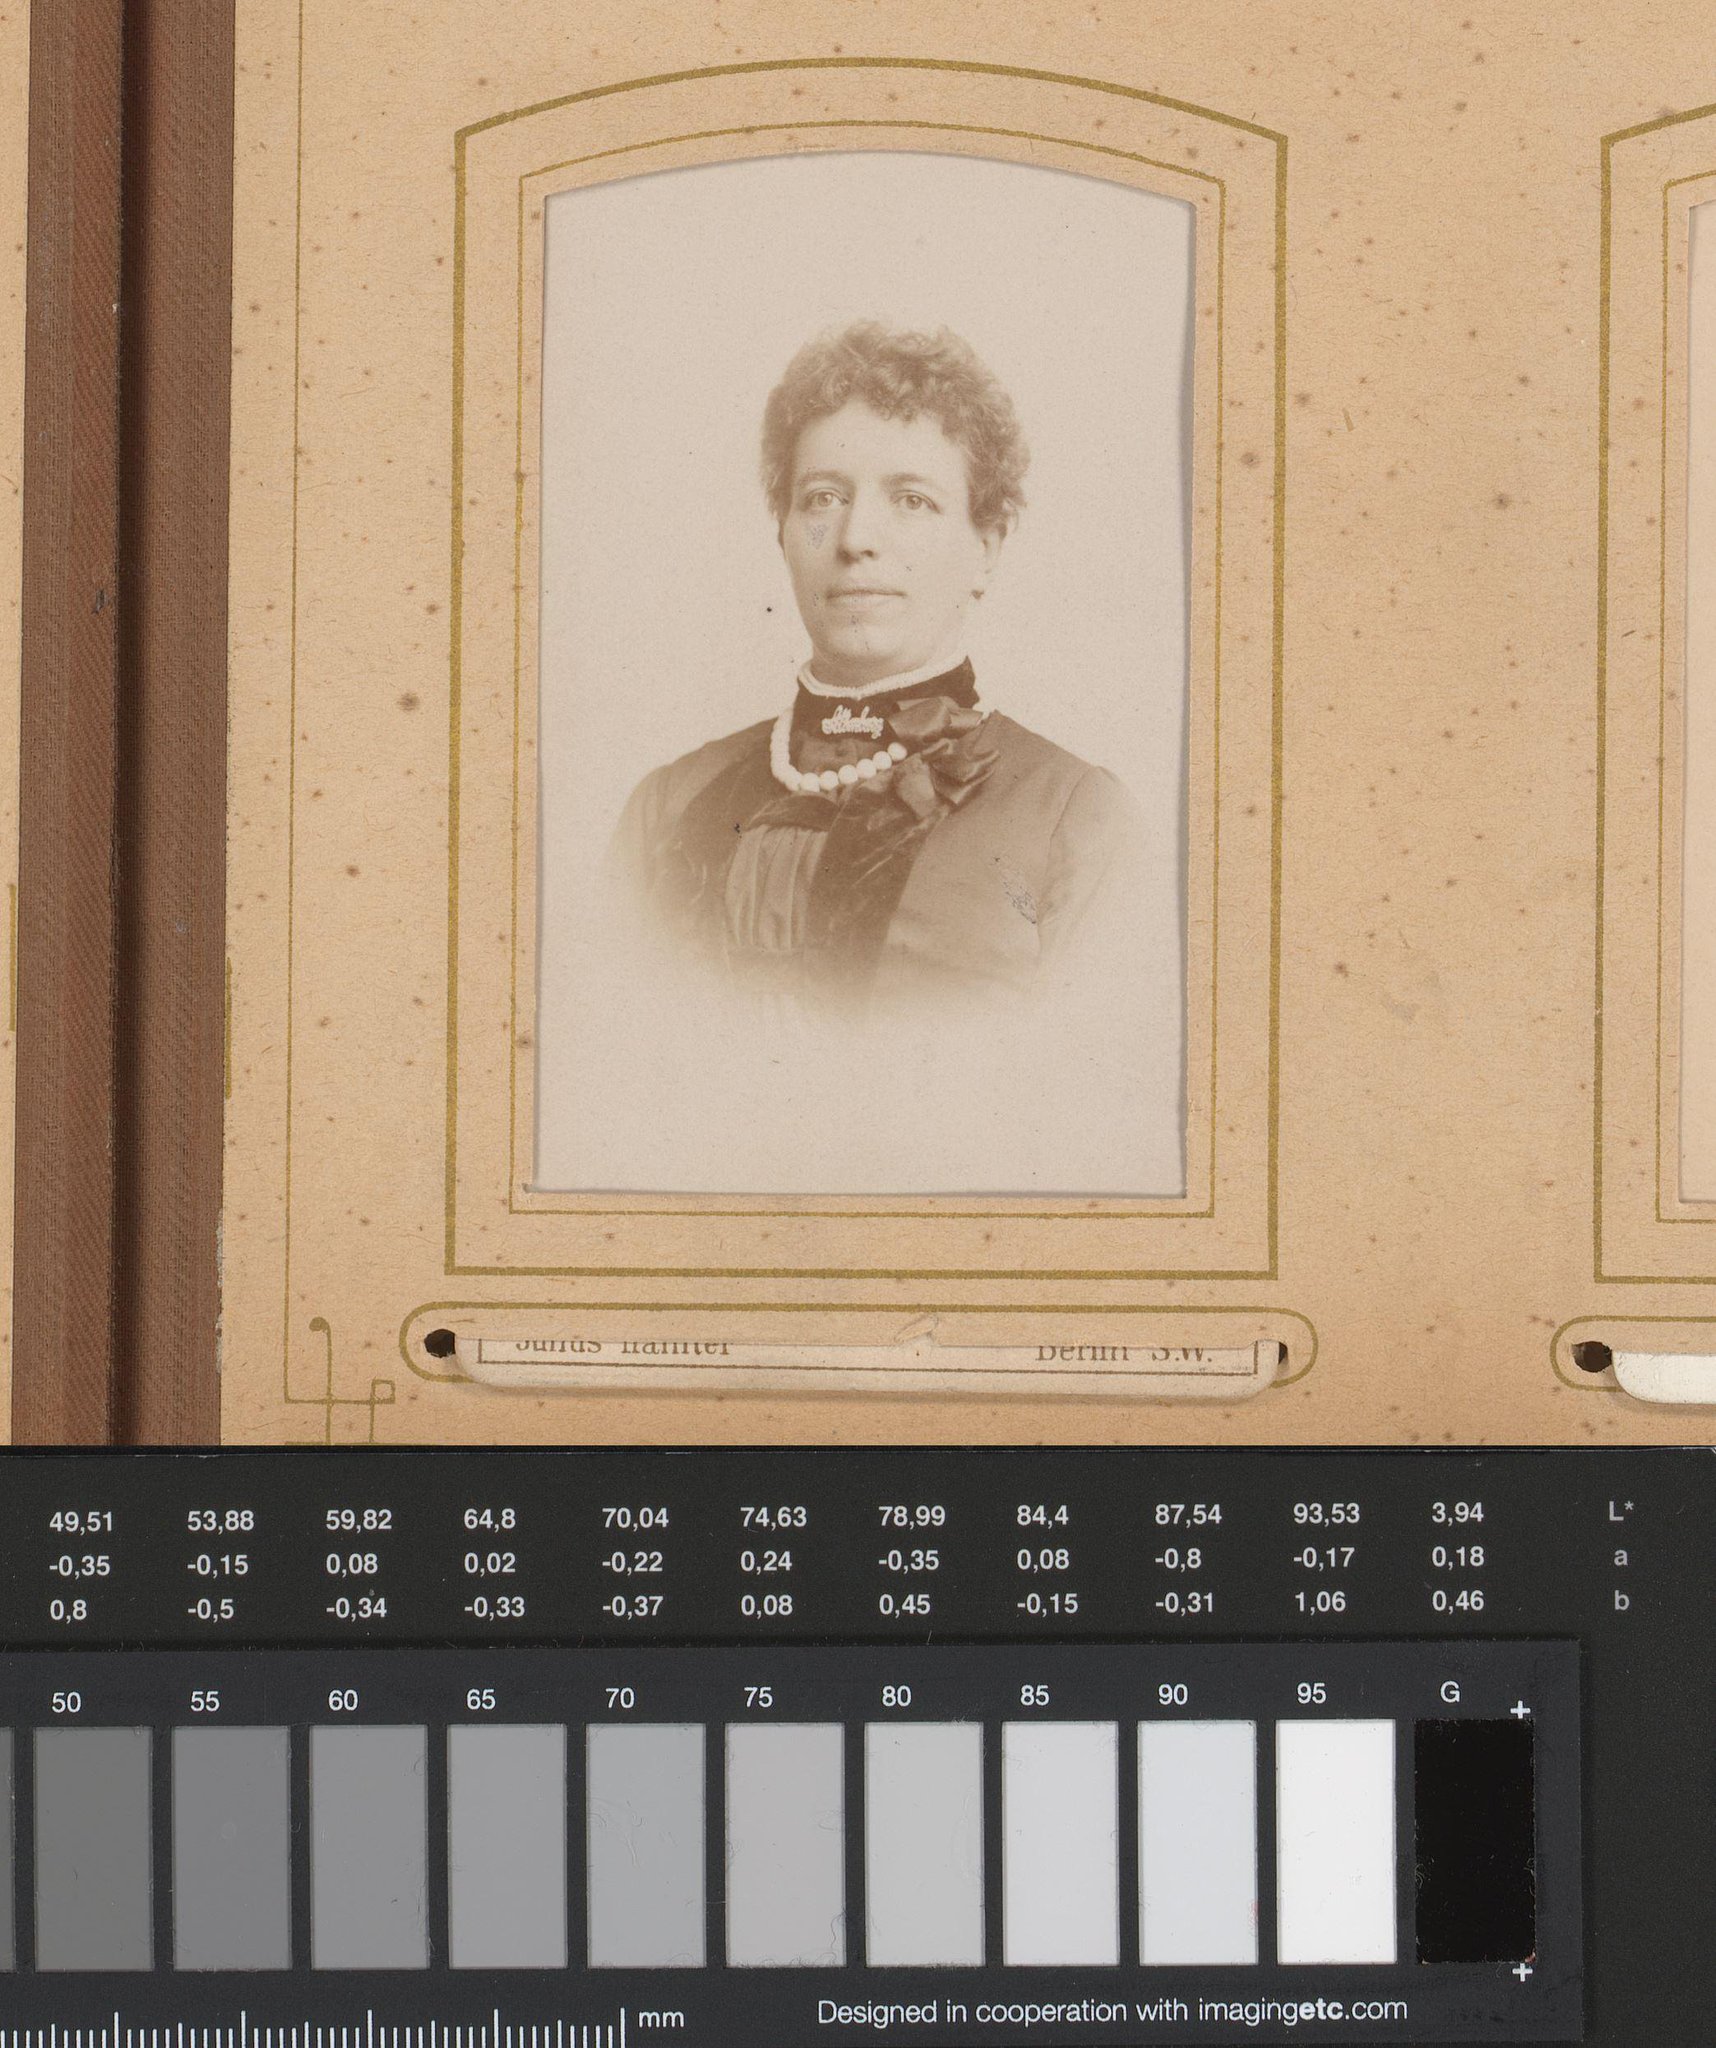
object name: photograph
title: Portret van een vrouw met halsketting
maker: julius halffter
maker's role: fotograaf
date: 1860-1900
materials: cardboard, photographic support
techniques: albumen print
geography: berlin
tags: historical persons - bb - woman, necklace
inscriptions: inscription: ‘PHOTOGRAPHIE/ Julius Halffter/ Friedrich-Str. 235/ im Chamisso Hause./ BERLIN S.W./ Die Platten bleiben für Nachbestellungen/ aufbewahrt und können jederzeit Bilder/ bis Lebensgrösse davon geliefert/ werden/’